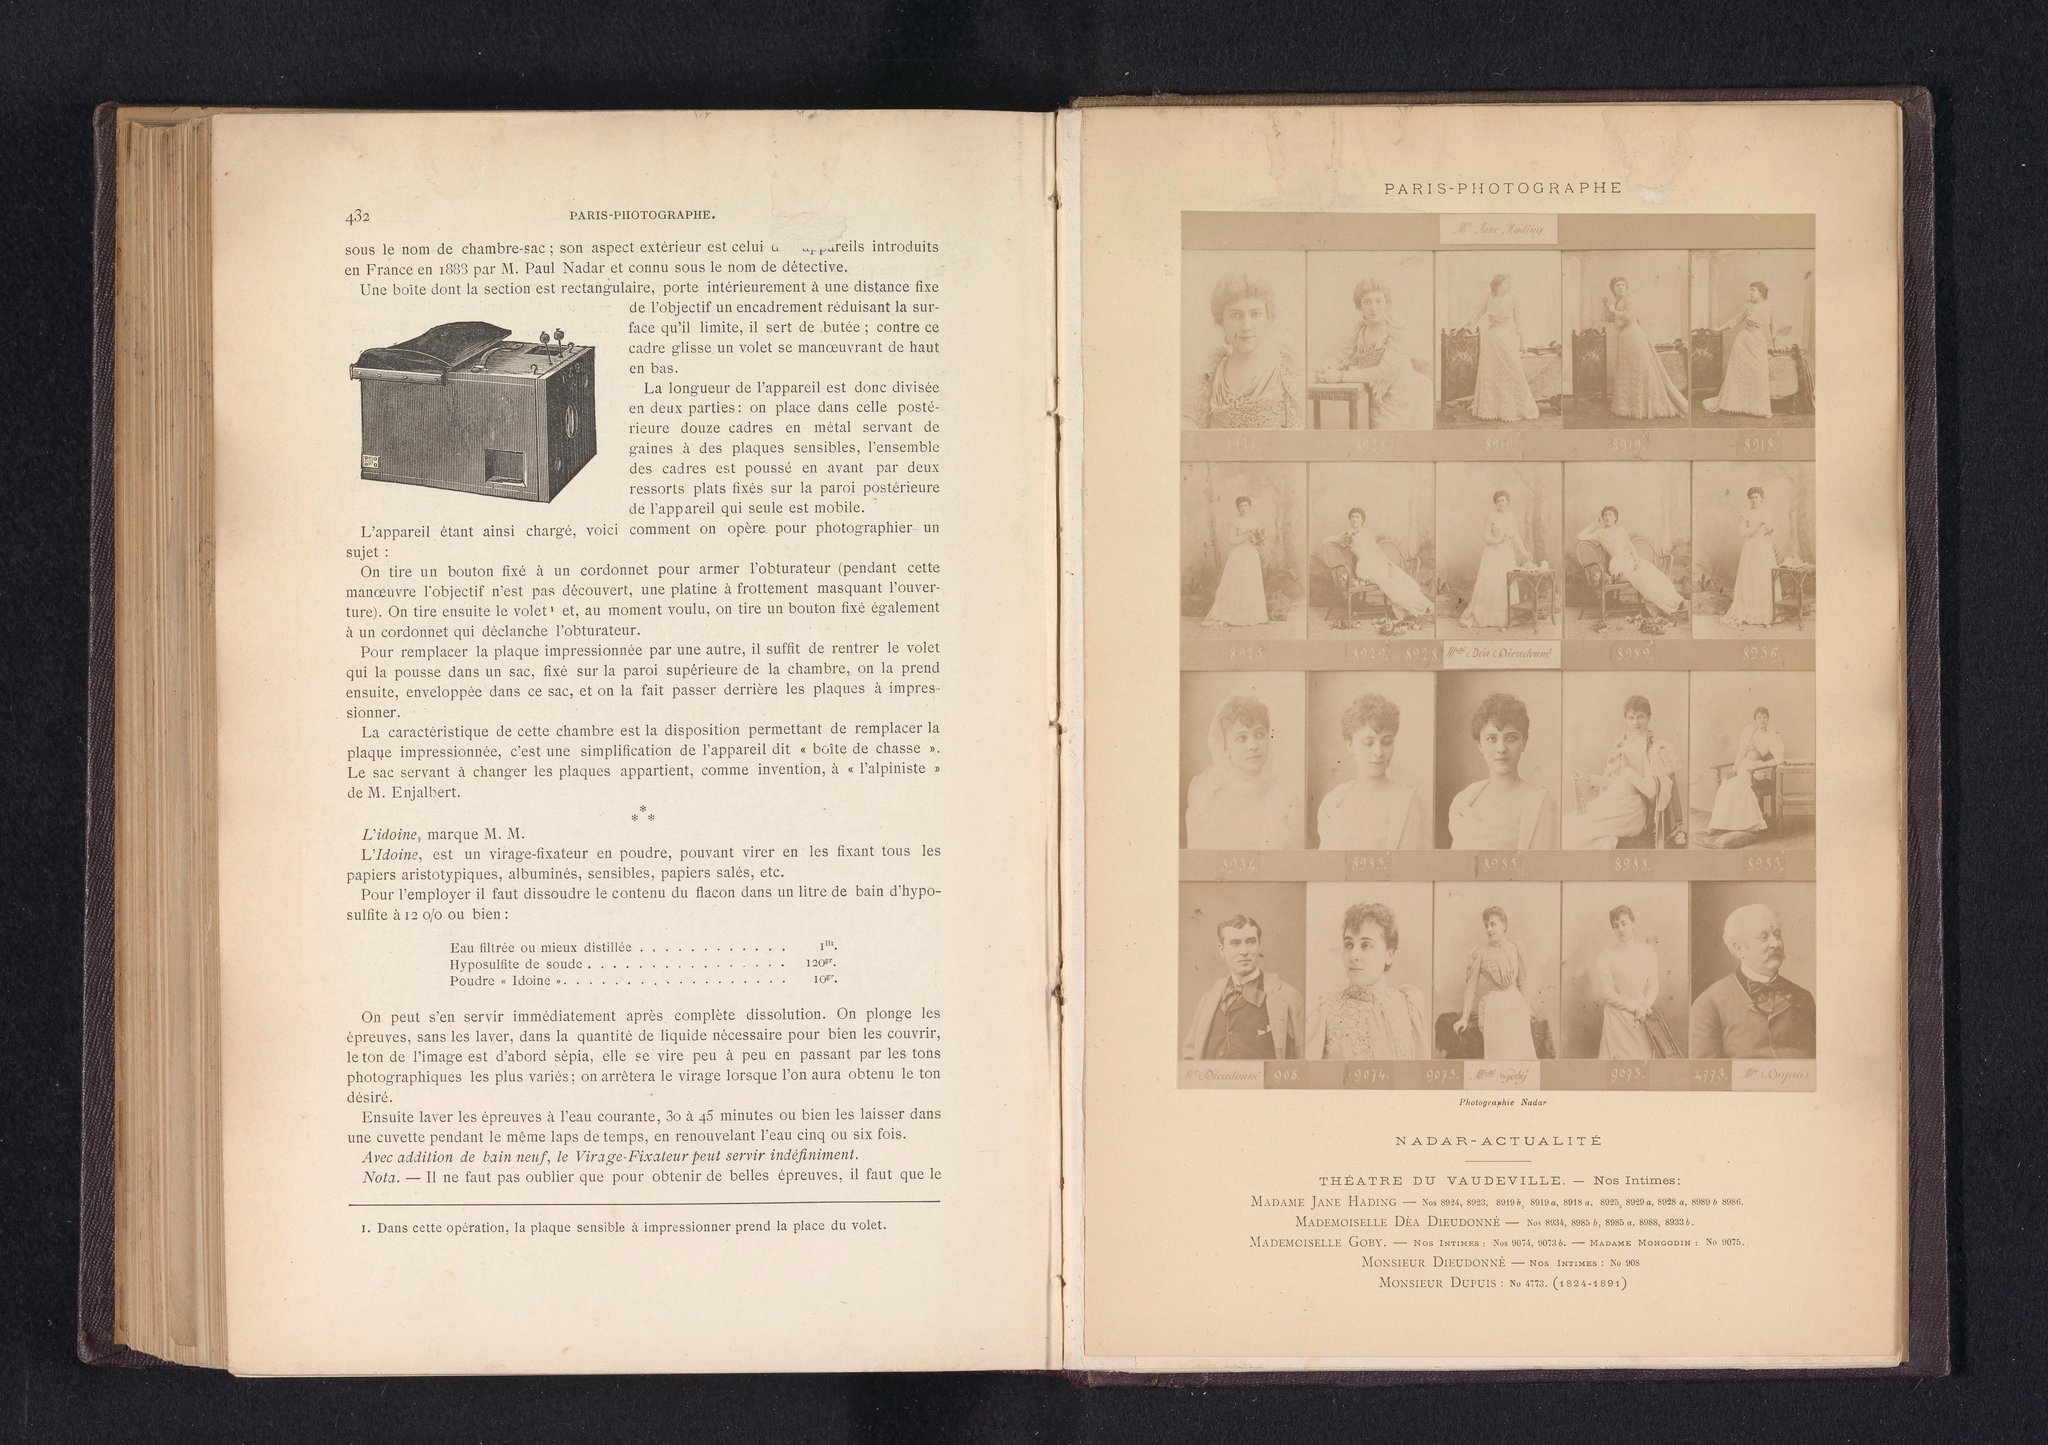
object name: photograph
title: Twintig portretten van acteurs en actrices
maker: félix nadar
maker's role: ballonvaarder, fotograaf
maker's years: 1820-1910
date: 1881-1891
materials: photographic support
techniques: albumen print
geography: paris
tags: stage costume, portrait of actor, actress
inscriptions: inscription: ‘Théatre du Vaudeville - Nos Intimes: (...)’, number: ‘8924 (...) 4773.’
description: Portretten van Jane Hading, Dèa Dieudonné, mevrouw Goby, Alfred Dieudonné en Adolphe Dupuis.